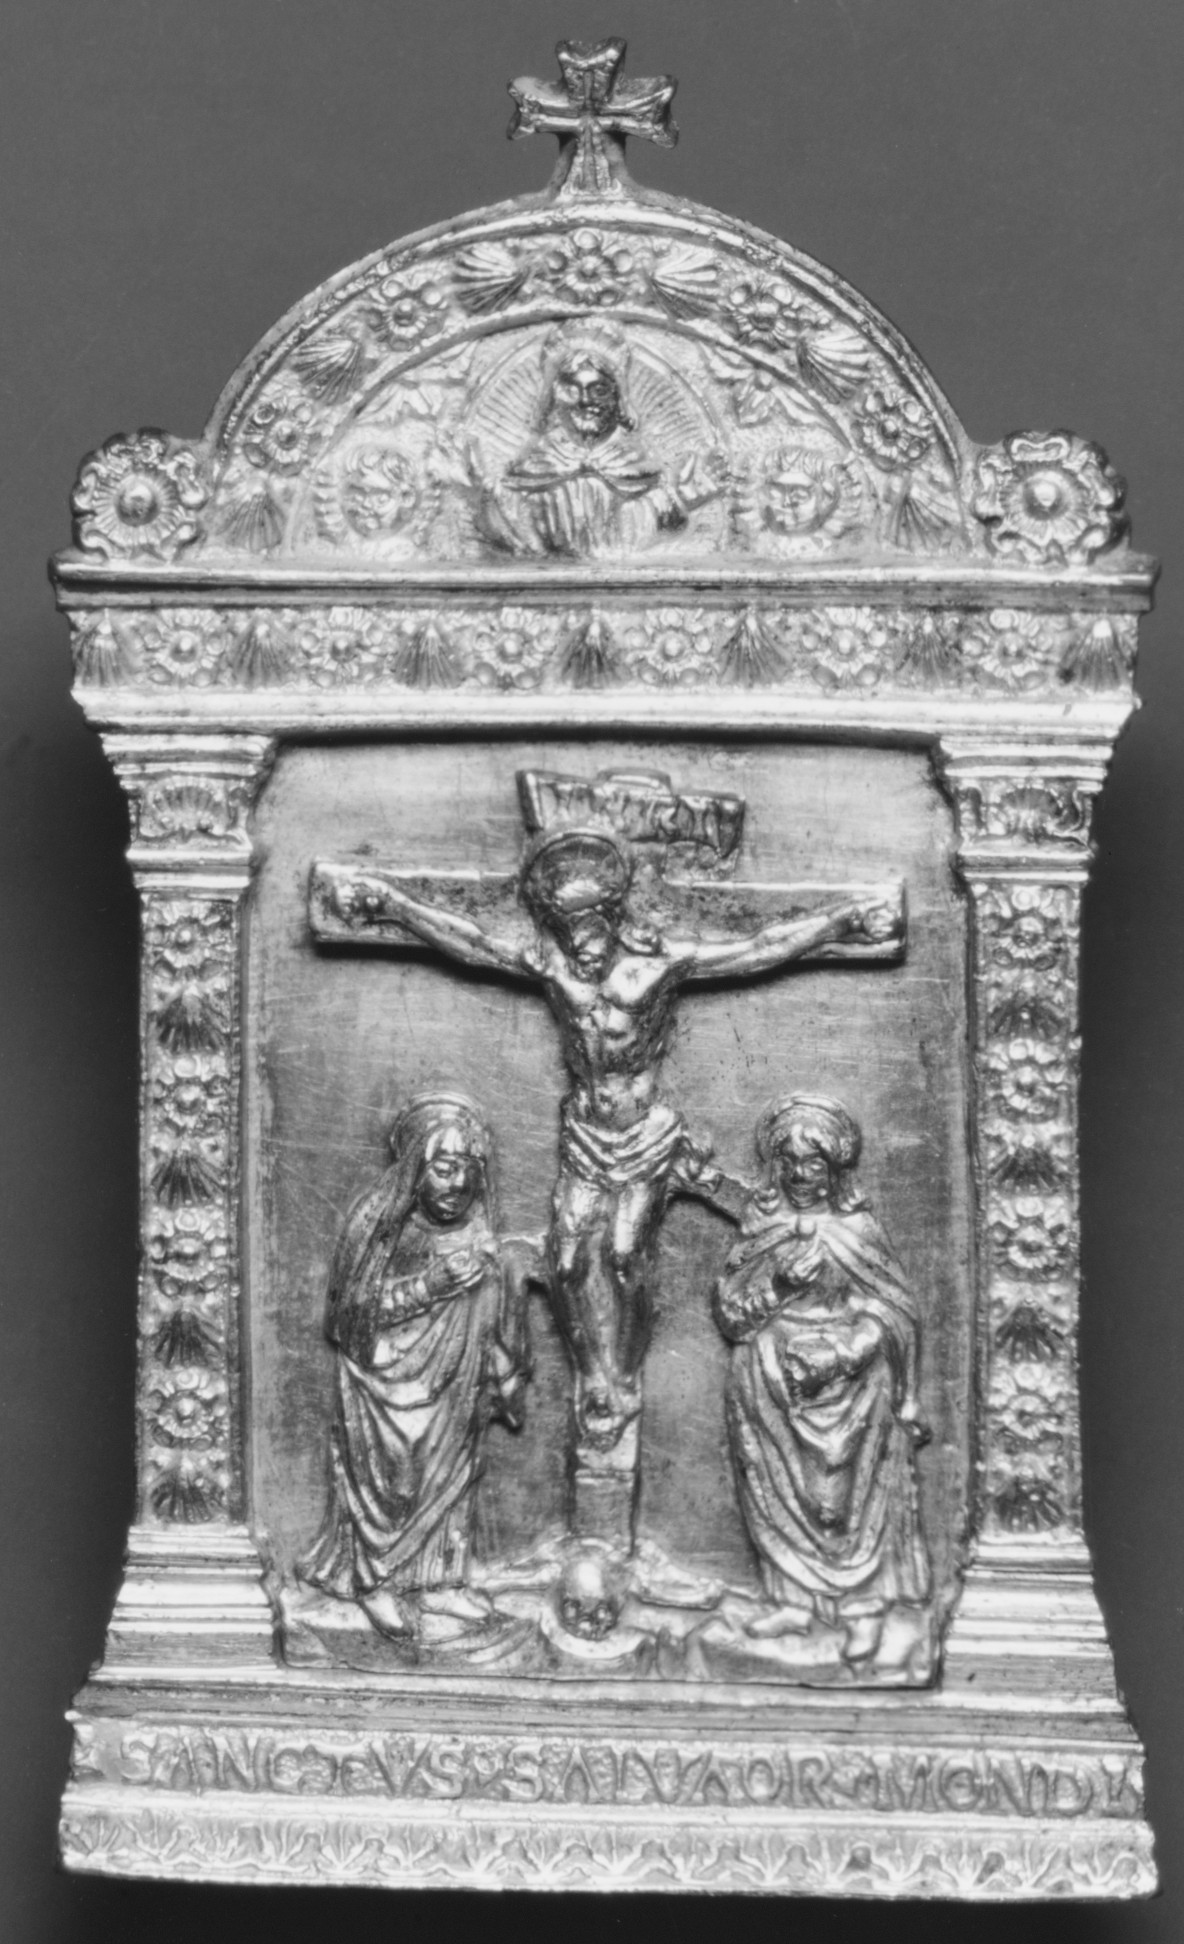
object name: plaquette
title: Crucifixion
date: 1467-1533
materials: gilt bronze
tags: christ,cross,crucifixion